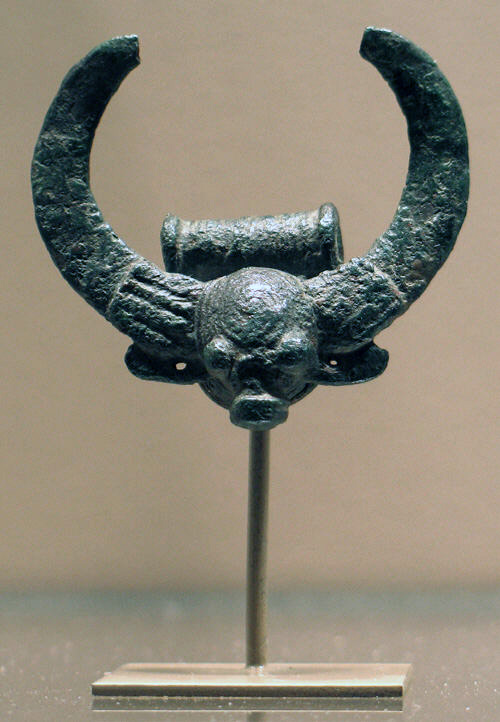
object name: pendant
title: Pendant with Buffalo Head?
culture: thai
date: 300 BCE-200 CE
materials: bronze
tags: buffalos